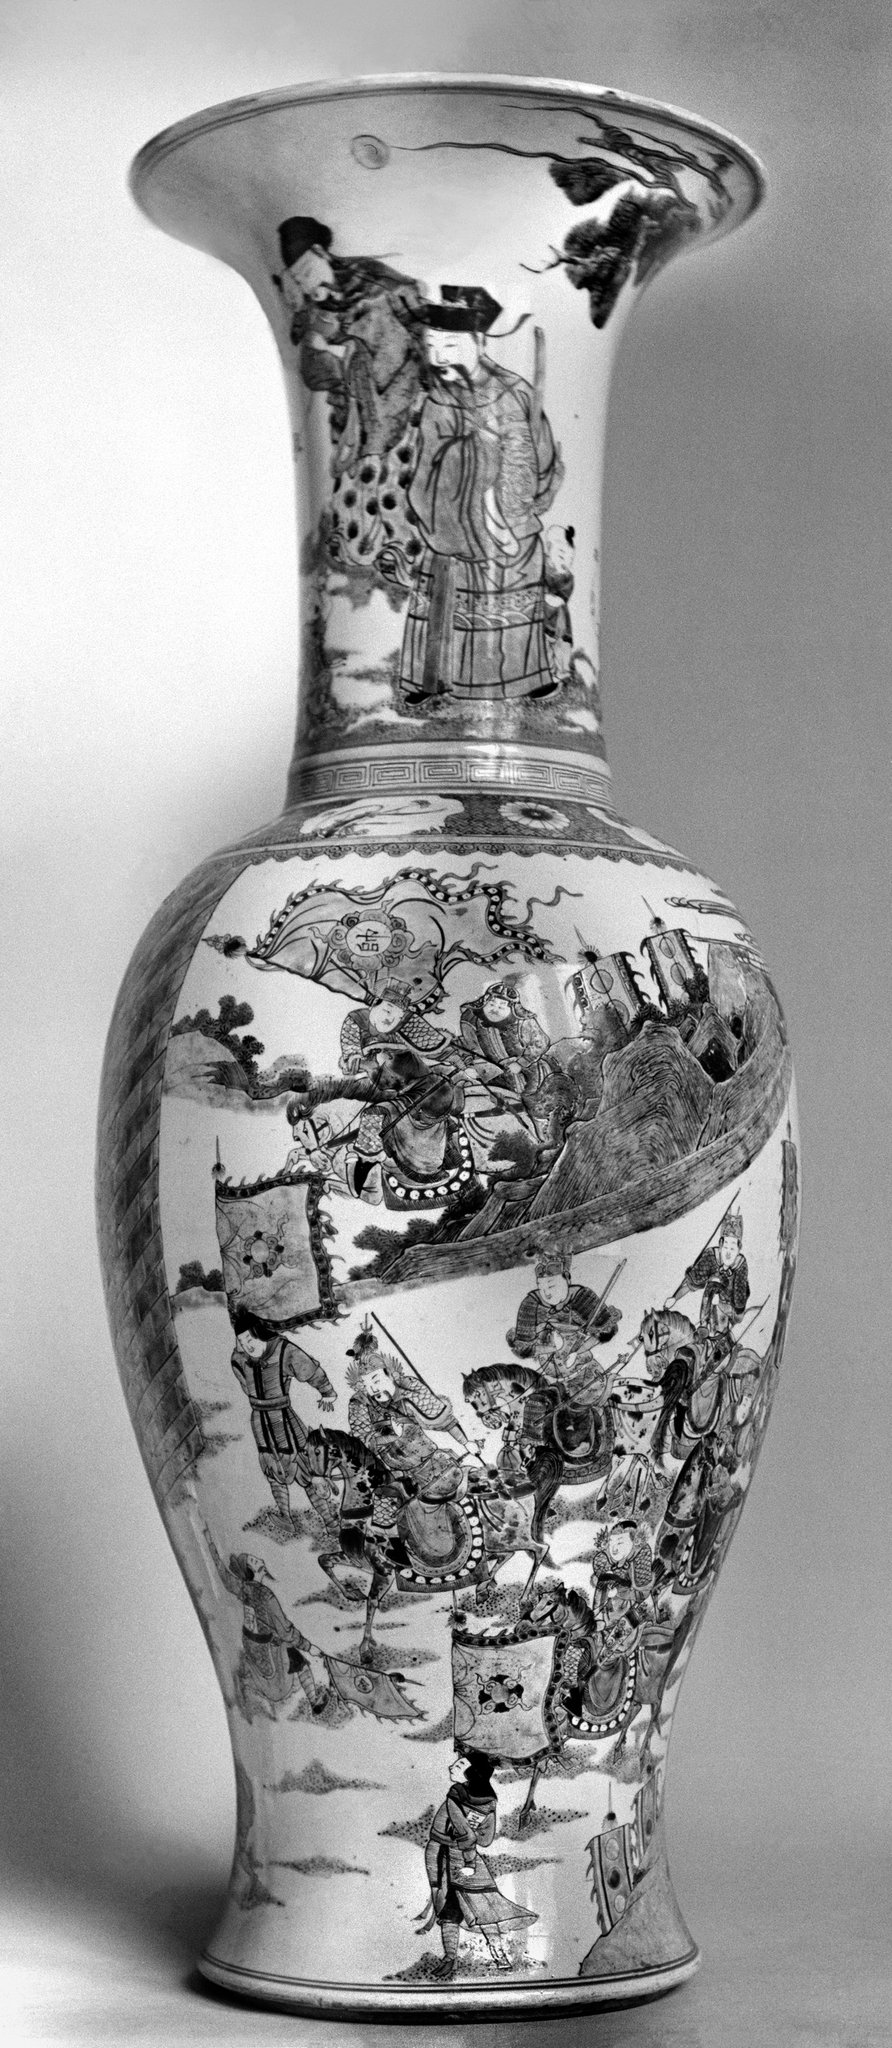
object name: vase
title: Vase with scene from Romance of the Three Kingdoms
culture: chinese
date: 1667-1733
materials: enamel, porcelain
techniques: overglaze, painting, polychrome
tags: men,horses